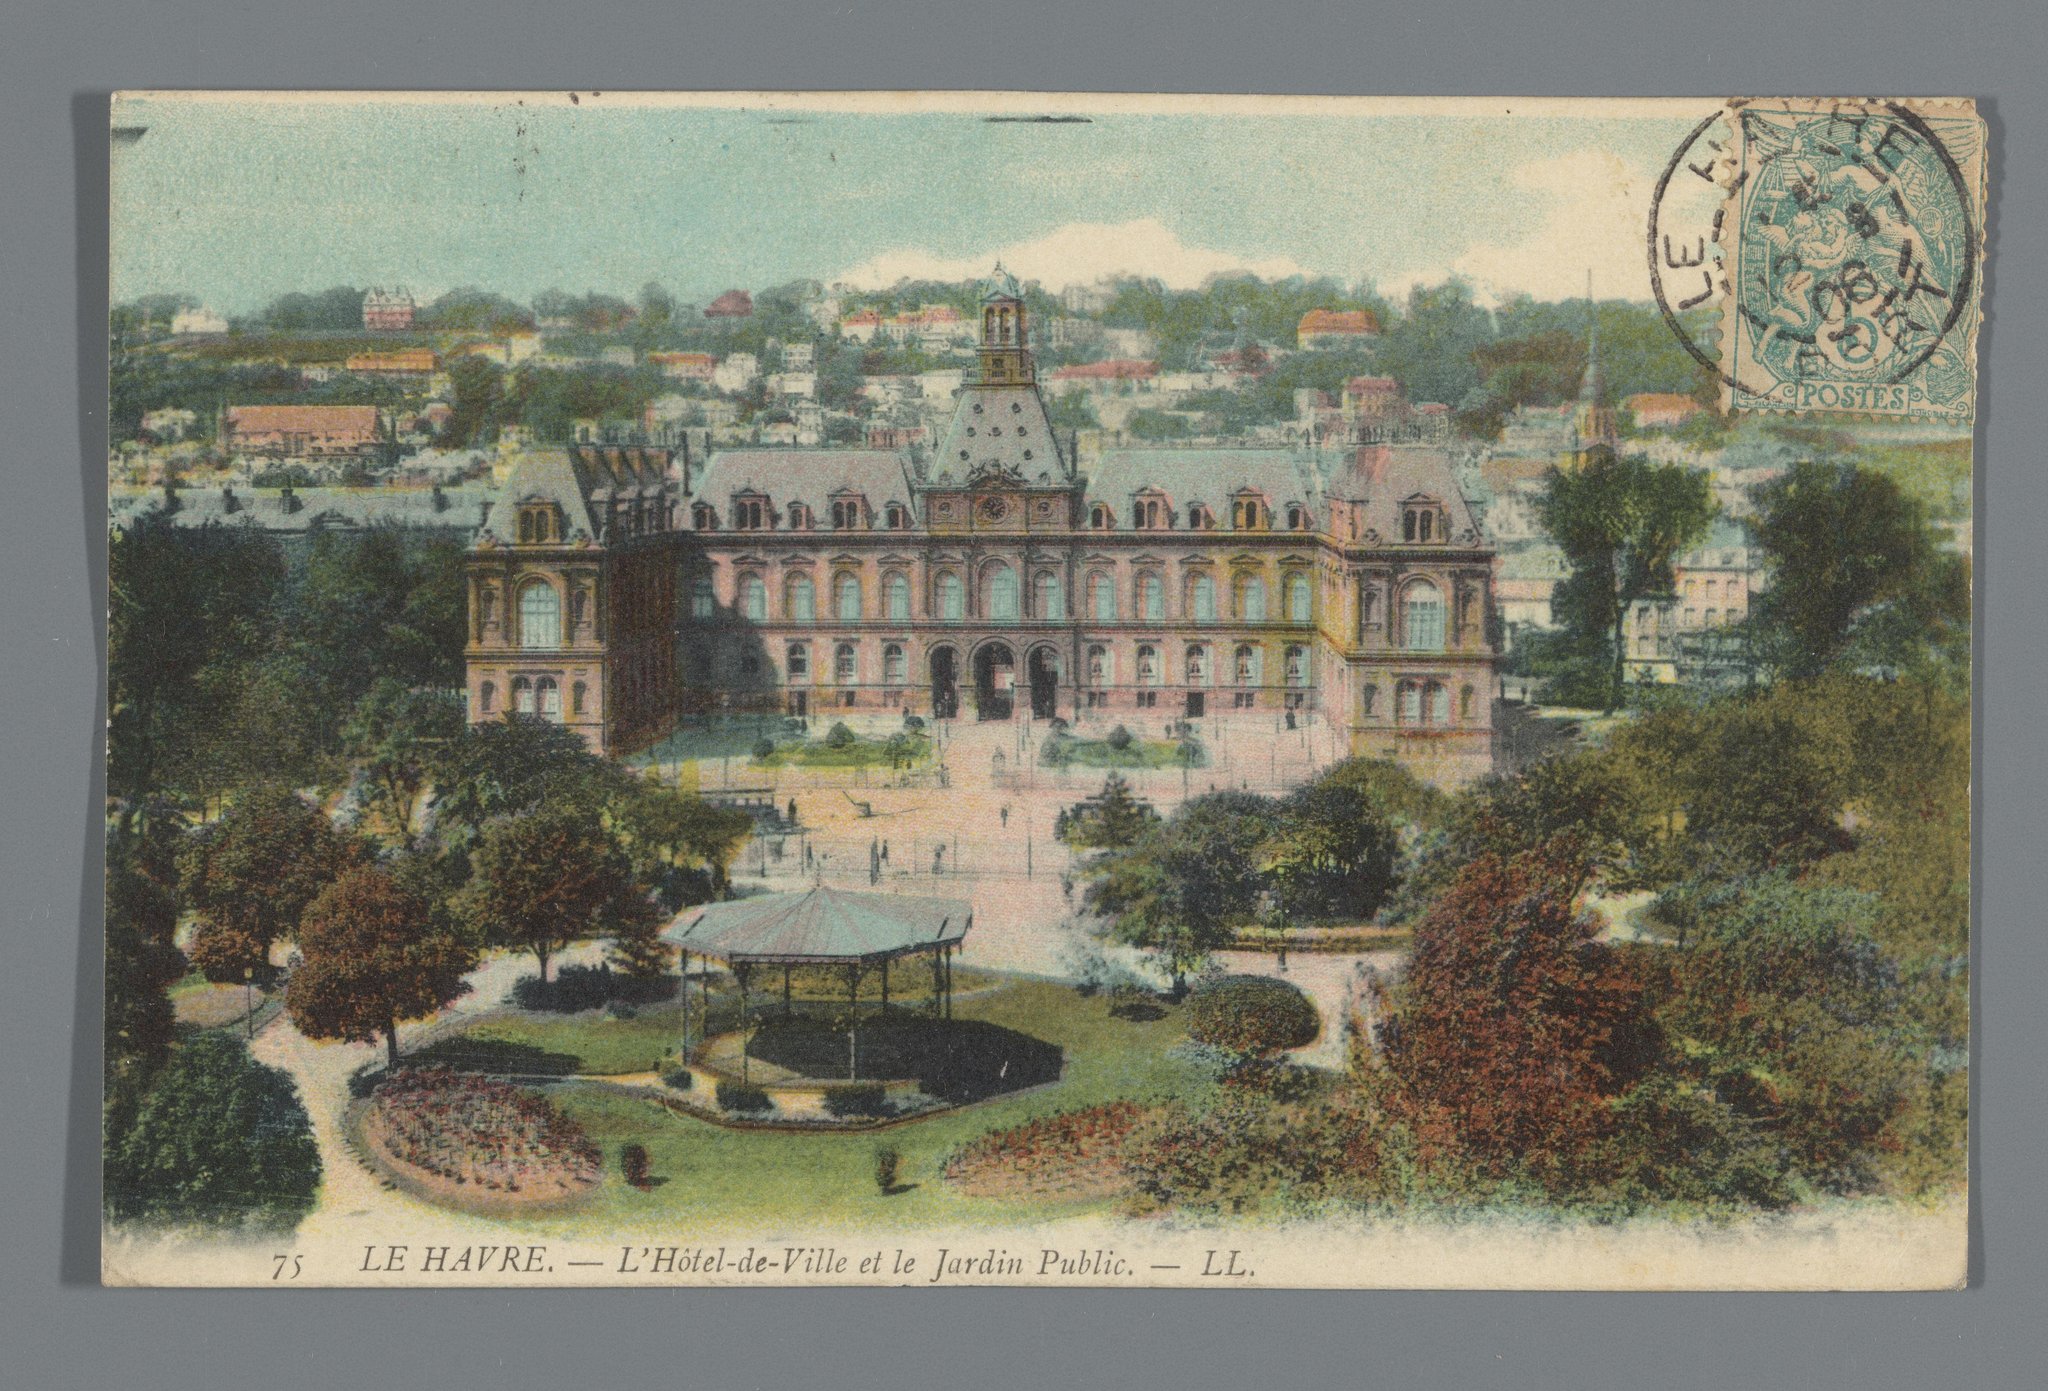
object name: photomechanical print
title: Gezicht op stadhuis van Le Havre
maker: Anonymous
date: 1906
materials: cardboard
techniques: photograph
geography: le havre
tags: townhall, le havre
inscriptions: number: ‘76’, inscription: ‘Mademoiselle Josephine Denis/ 32 Rue de l'Espérance/ 13e Paris’, stamp: ‘Le Havre/ le 12 8 06/ Port’, number: ‘75’, inscription: ‘Carte Postale (...) Adresse’